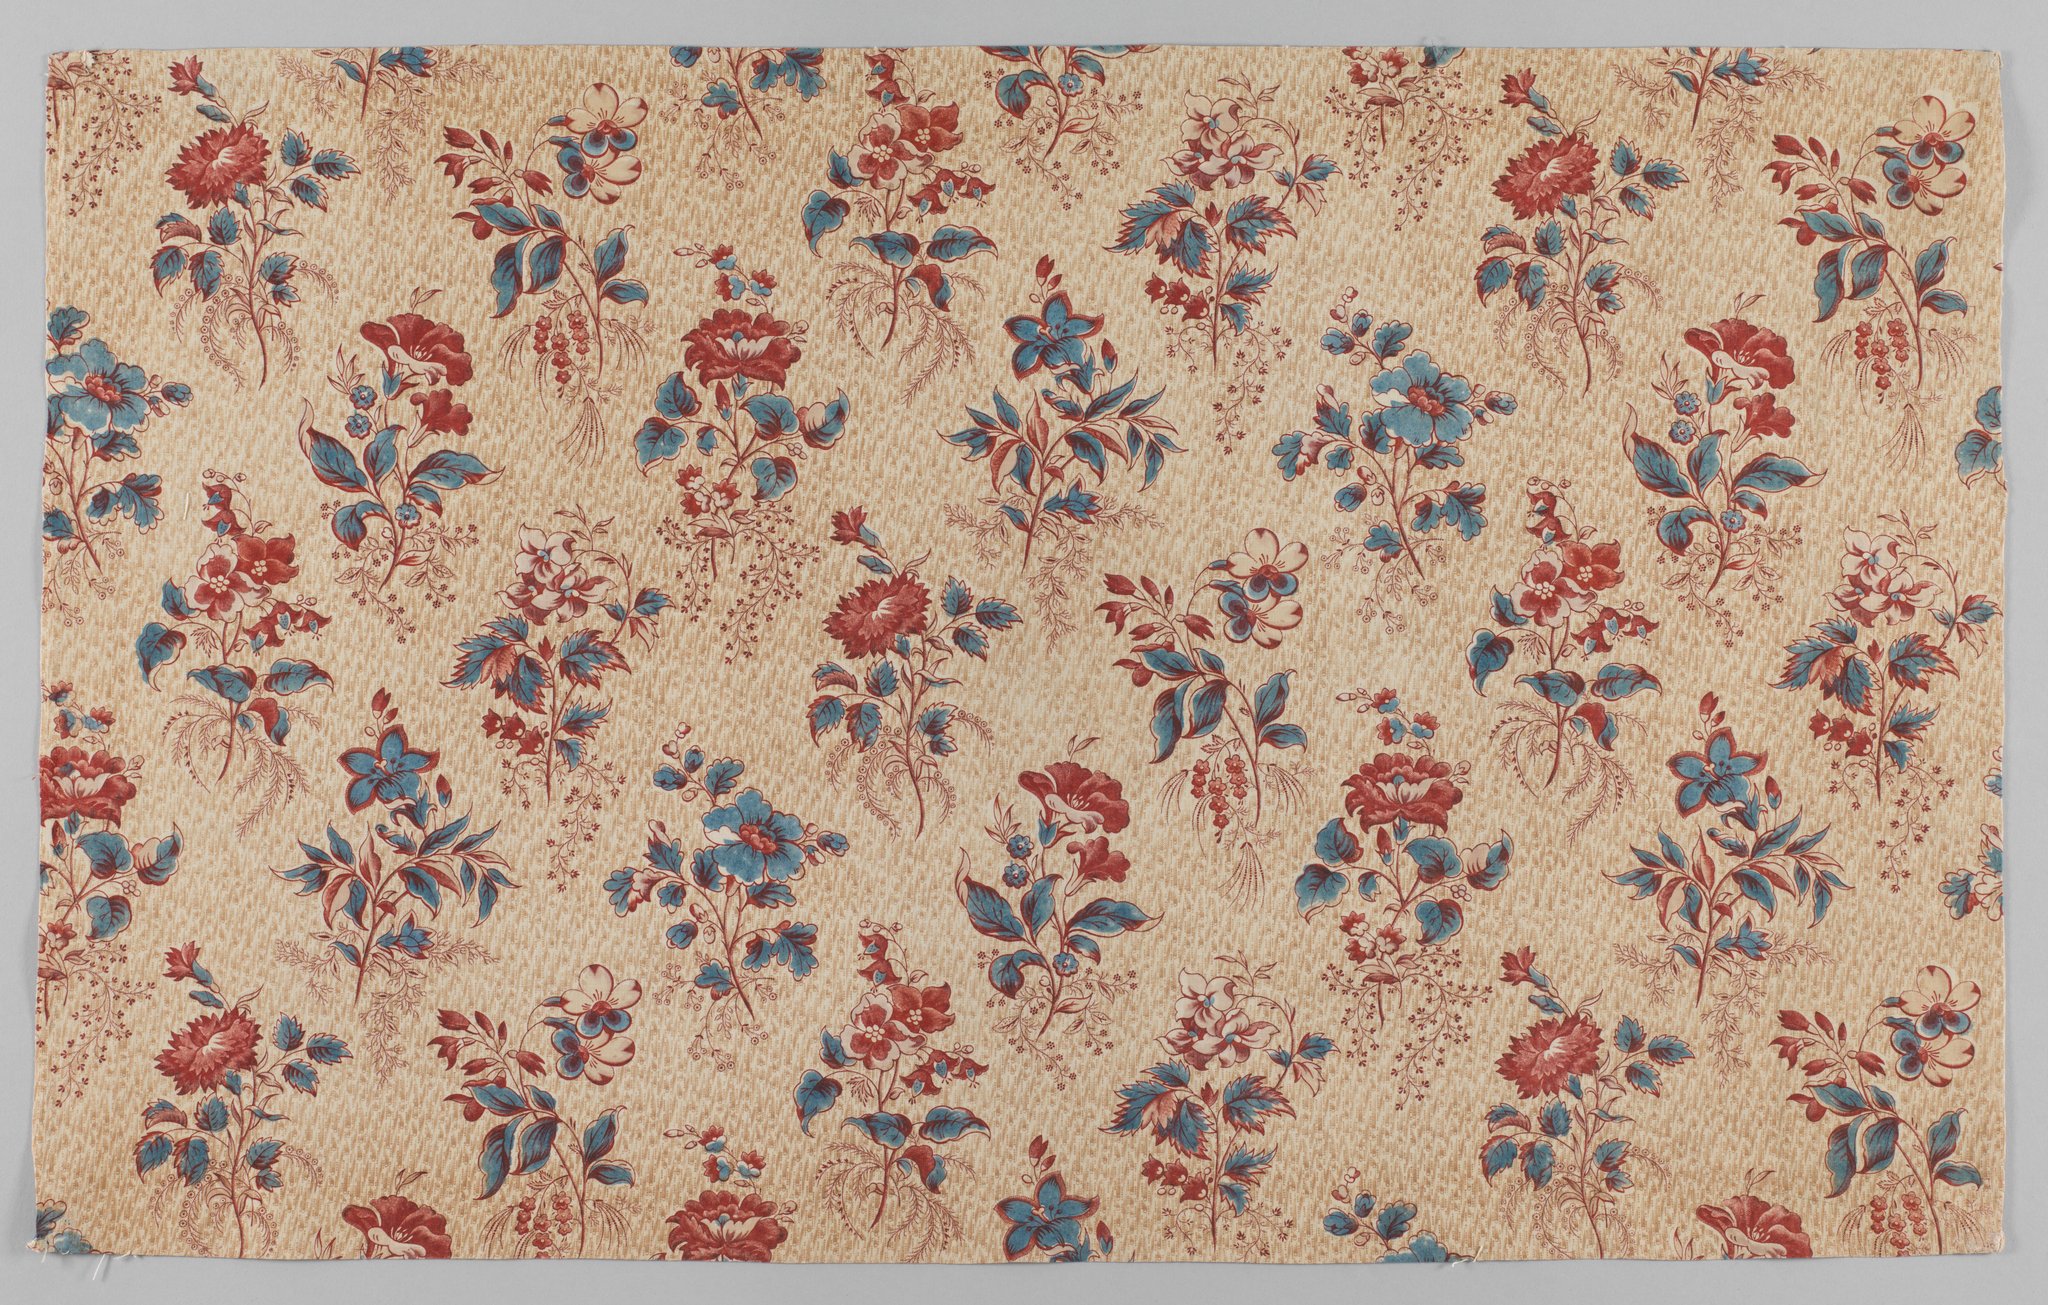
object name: piece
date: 1830-1840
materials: cotton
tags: flowers